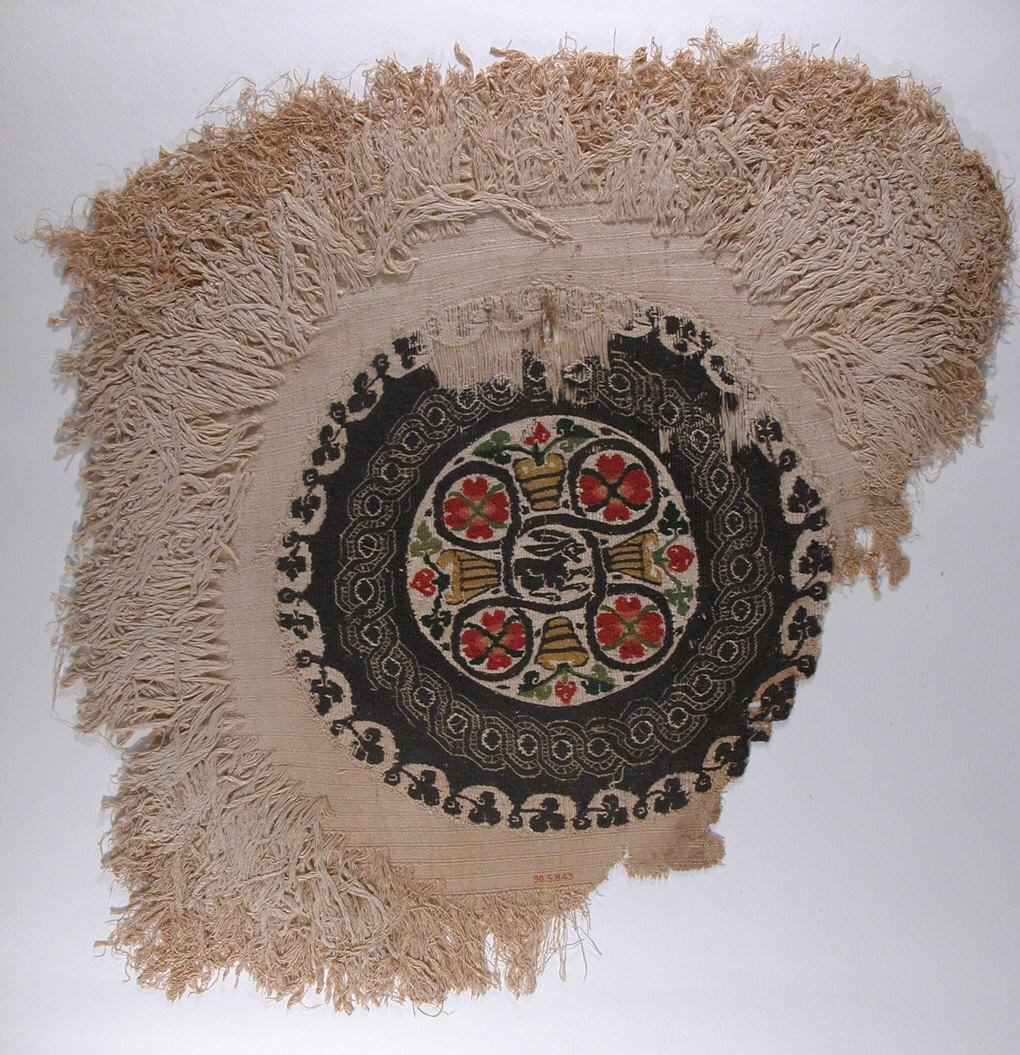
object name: textile fragment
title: Fragment with a Roundel and Loop Pile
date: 401-600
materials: linen, wool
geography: egypt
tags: animals,flowers